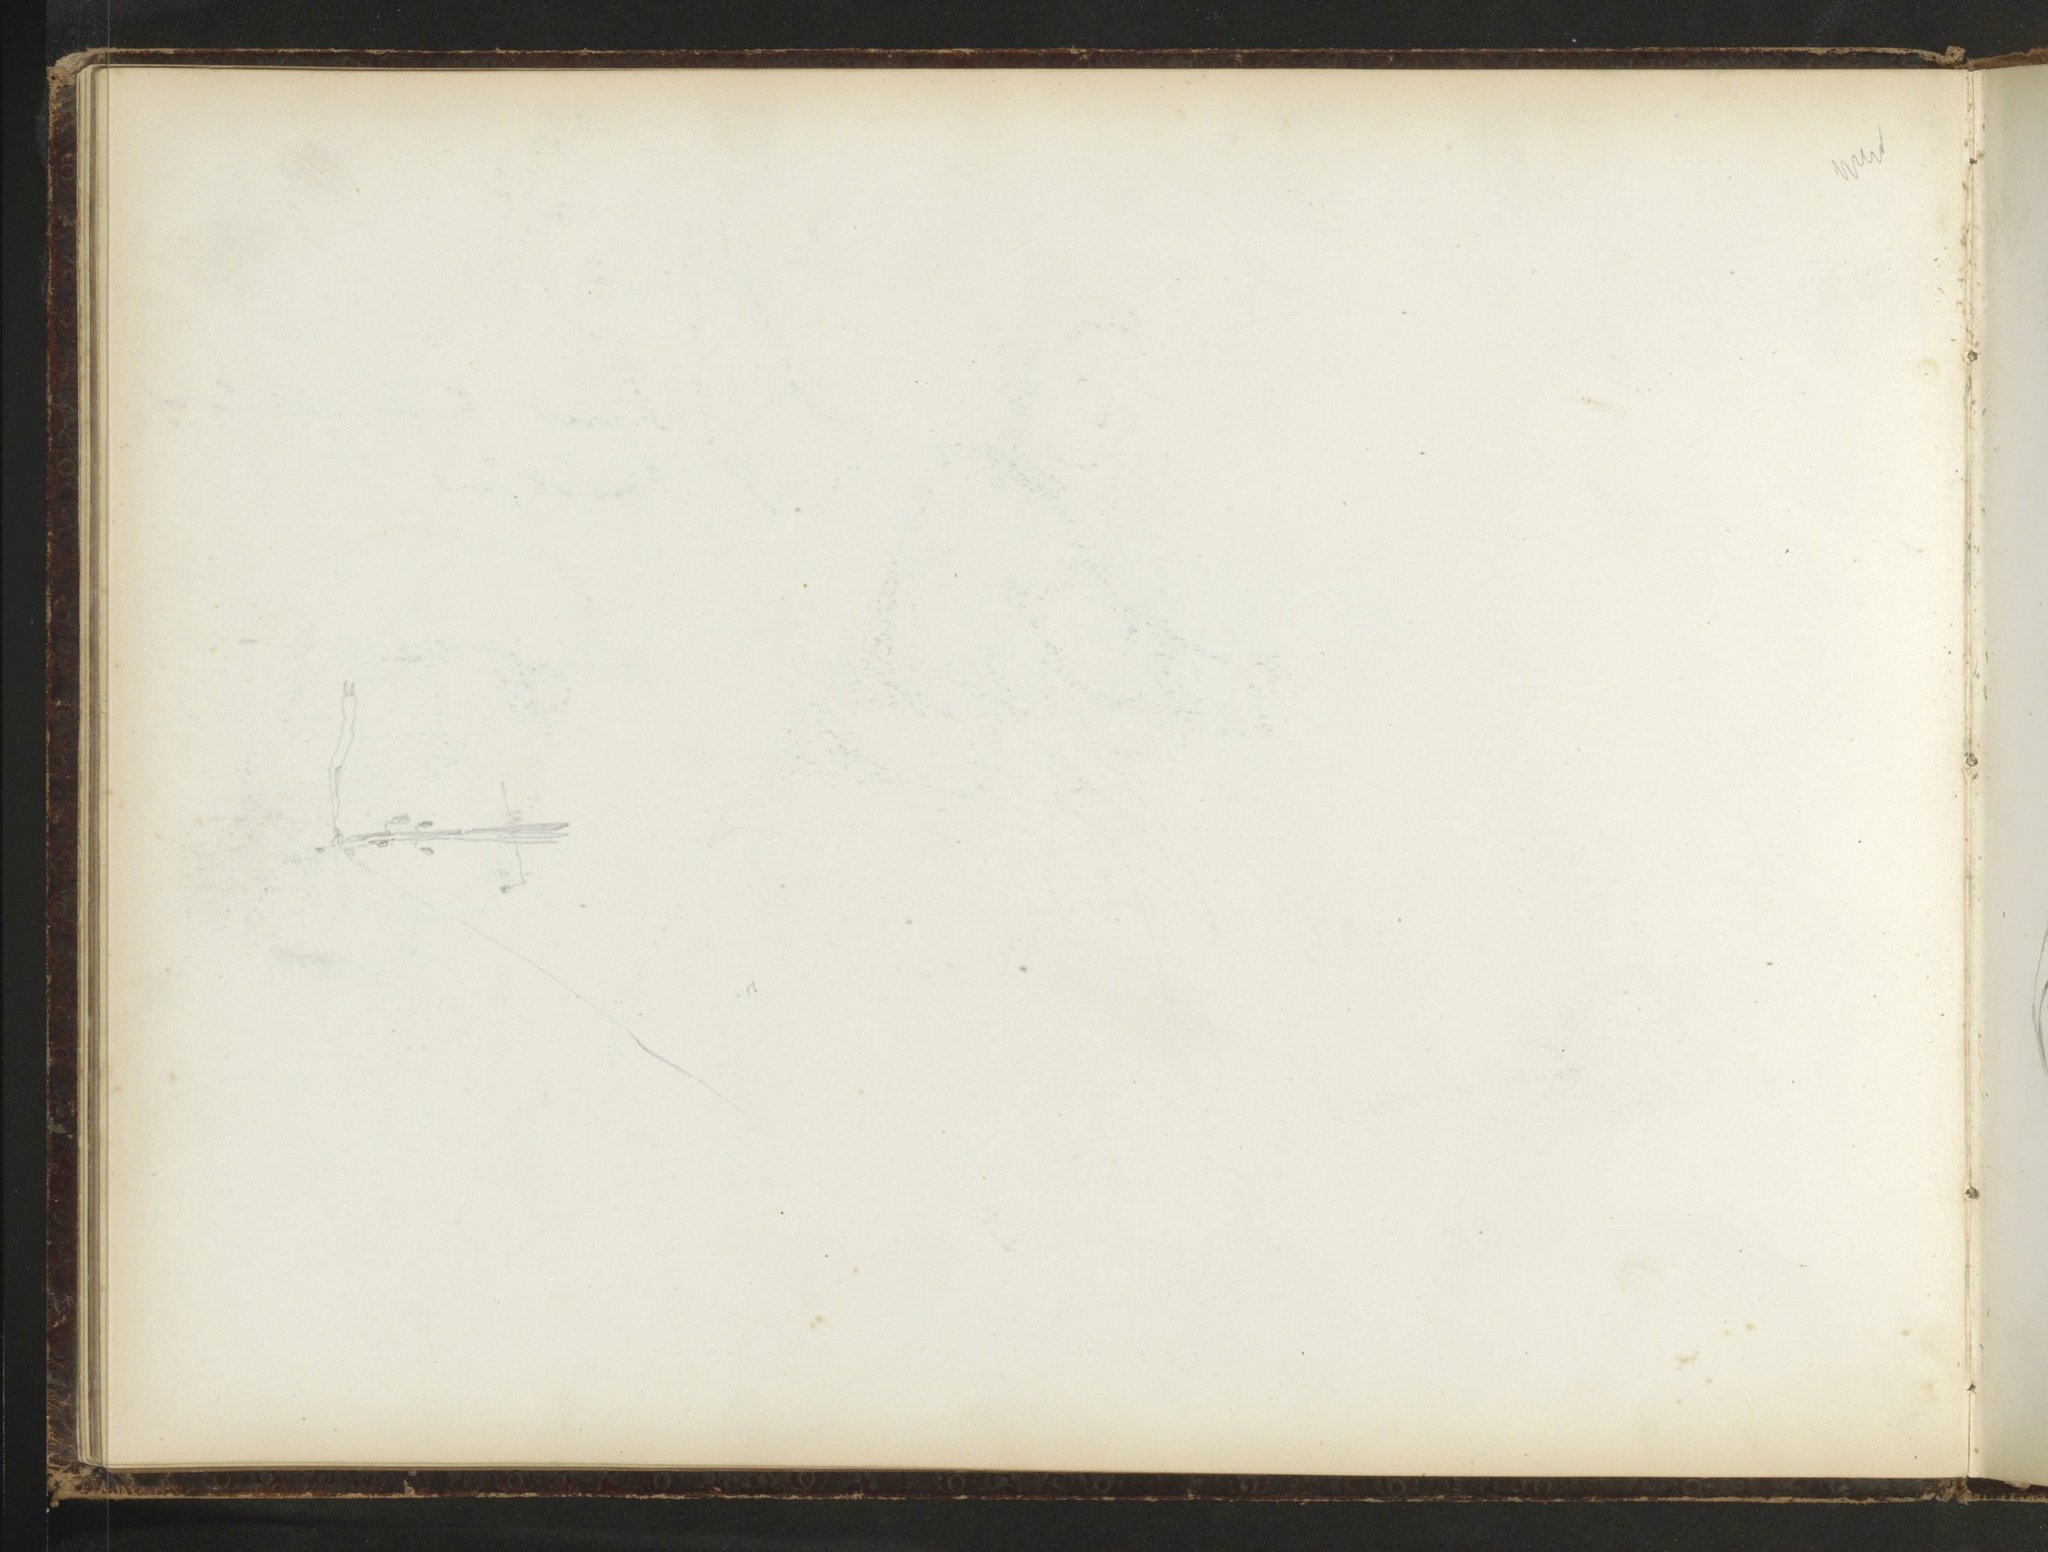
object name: sketchbook leaf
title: Studie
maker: reinier craeyvanger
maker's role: draughtsman, print maker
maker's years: 1812-1880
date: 1822-1880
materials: paper, pencil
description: Blad 11 verso uit een schetsboek met 45 bladen.